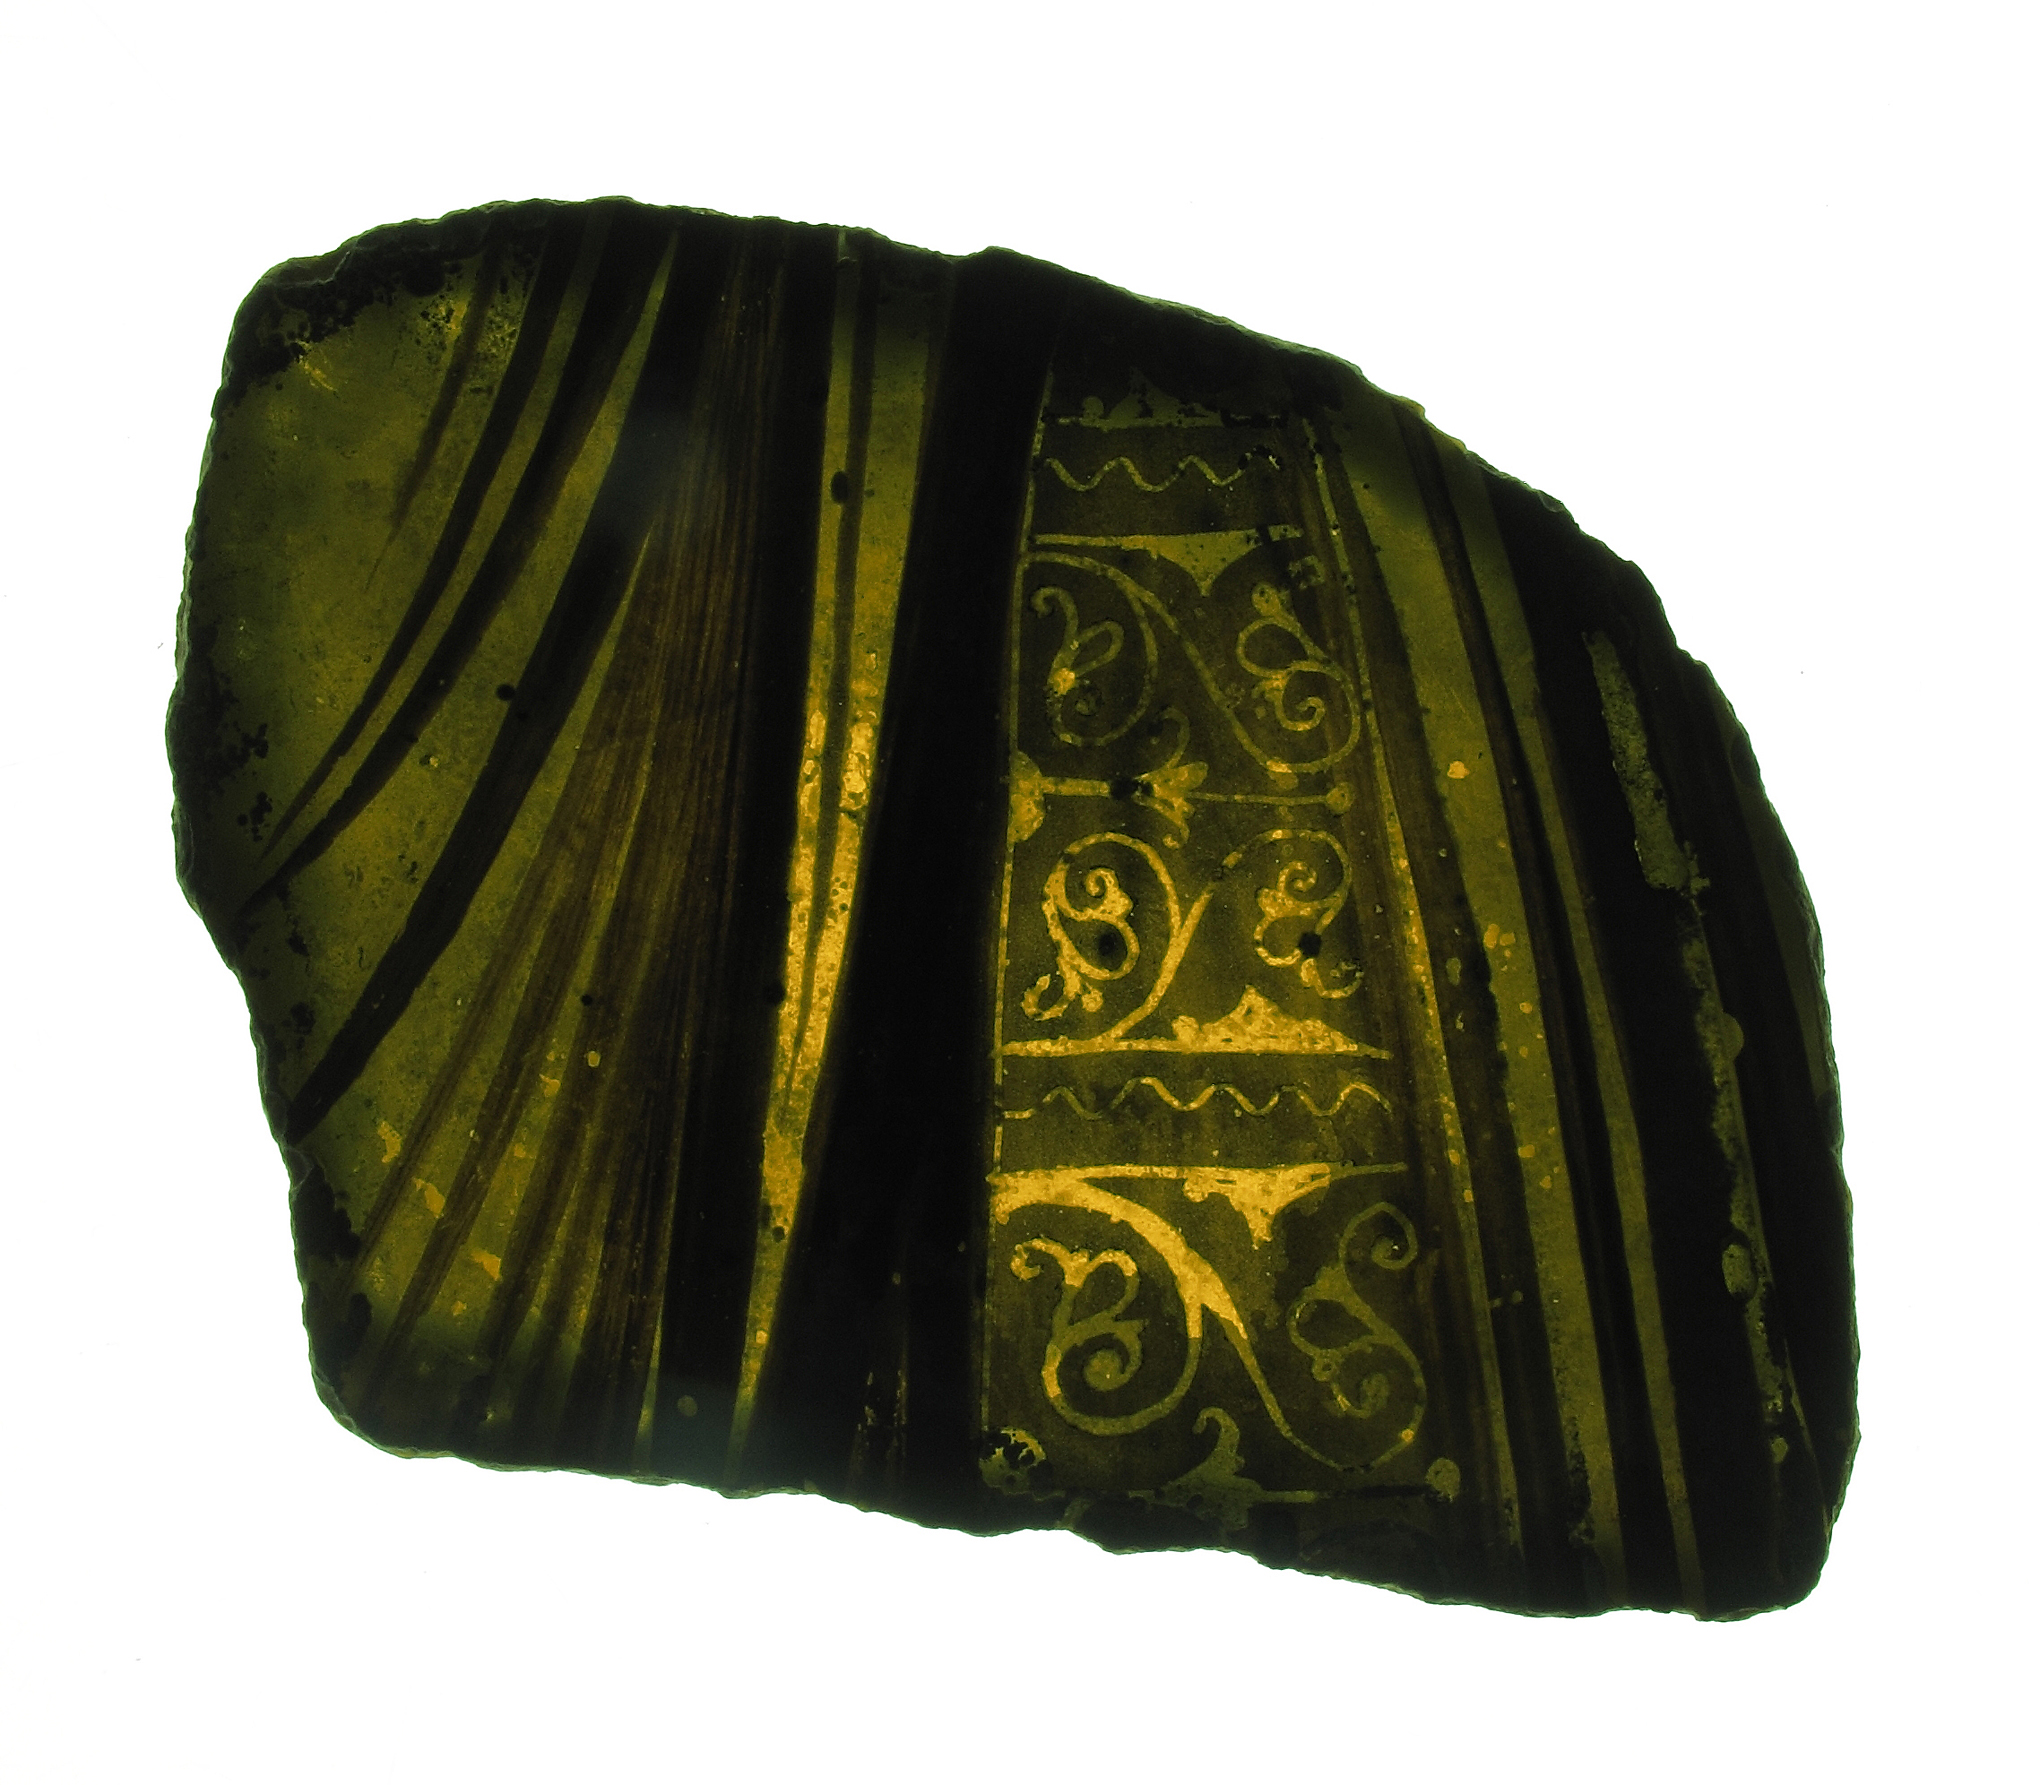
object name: fragment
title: Glass Fragment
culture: european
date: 1401-1500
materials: glass, metal